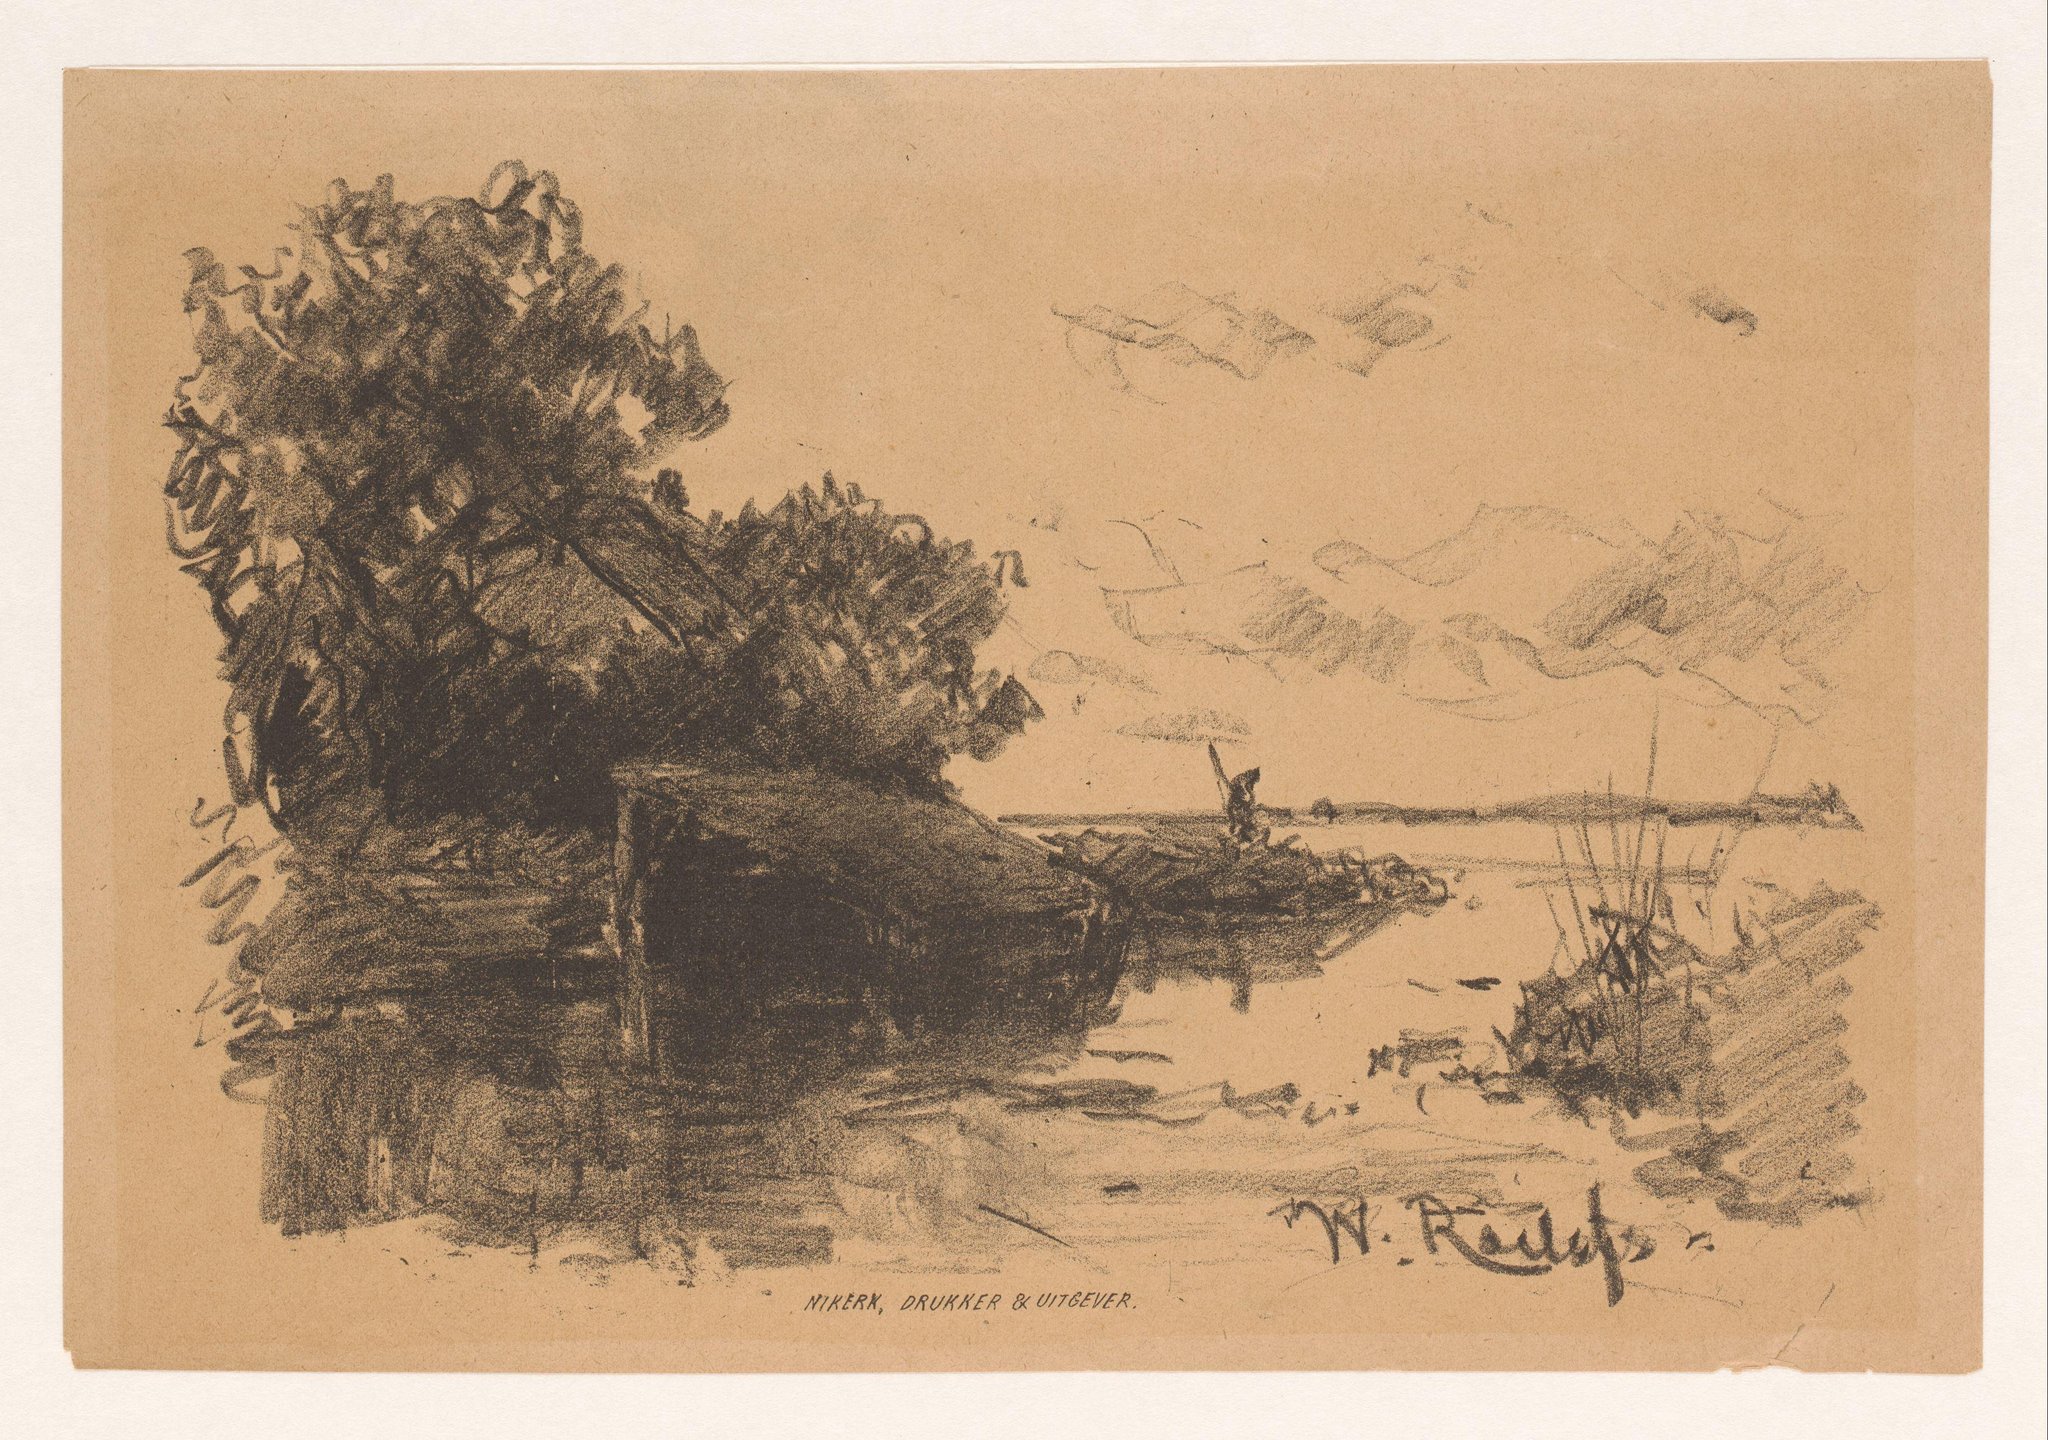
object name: print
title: Polderlandschap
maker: willem roelofs (i)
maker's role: draughtsman, painter, print maker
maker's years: 1822-1897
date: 1832-1897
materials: paper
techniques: lithograph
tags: landscapes with waters, waterscapes, seascapes (in the temperate zone) (+ landscape with figures, staffage)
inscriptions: collector's mark: Lugt 2760, collector's mark: Lugt 2166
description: In een waterlandschap staat een figuur op de oever.